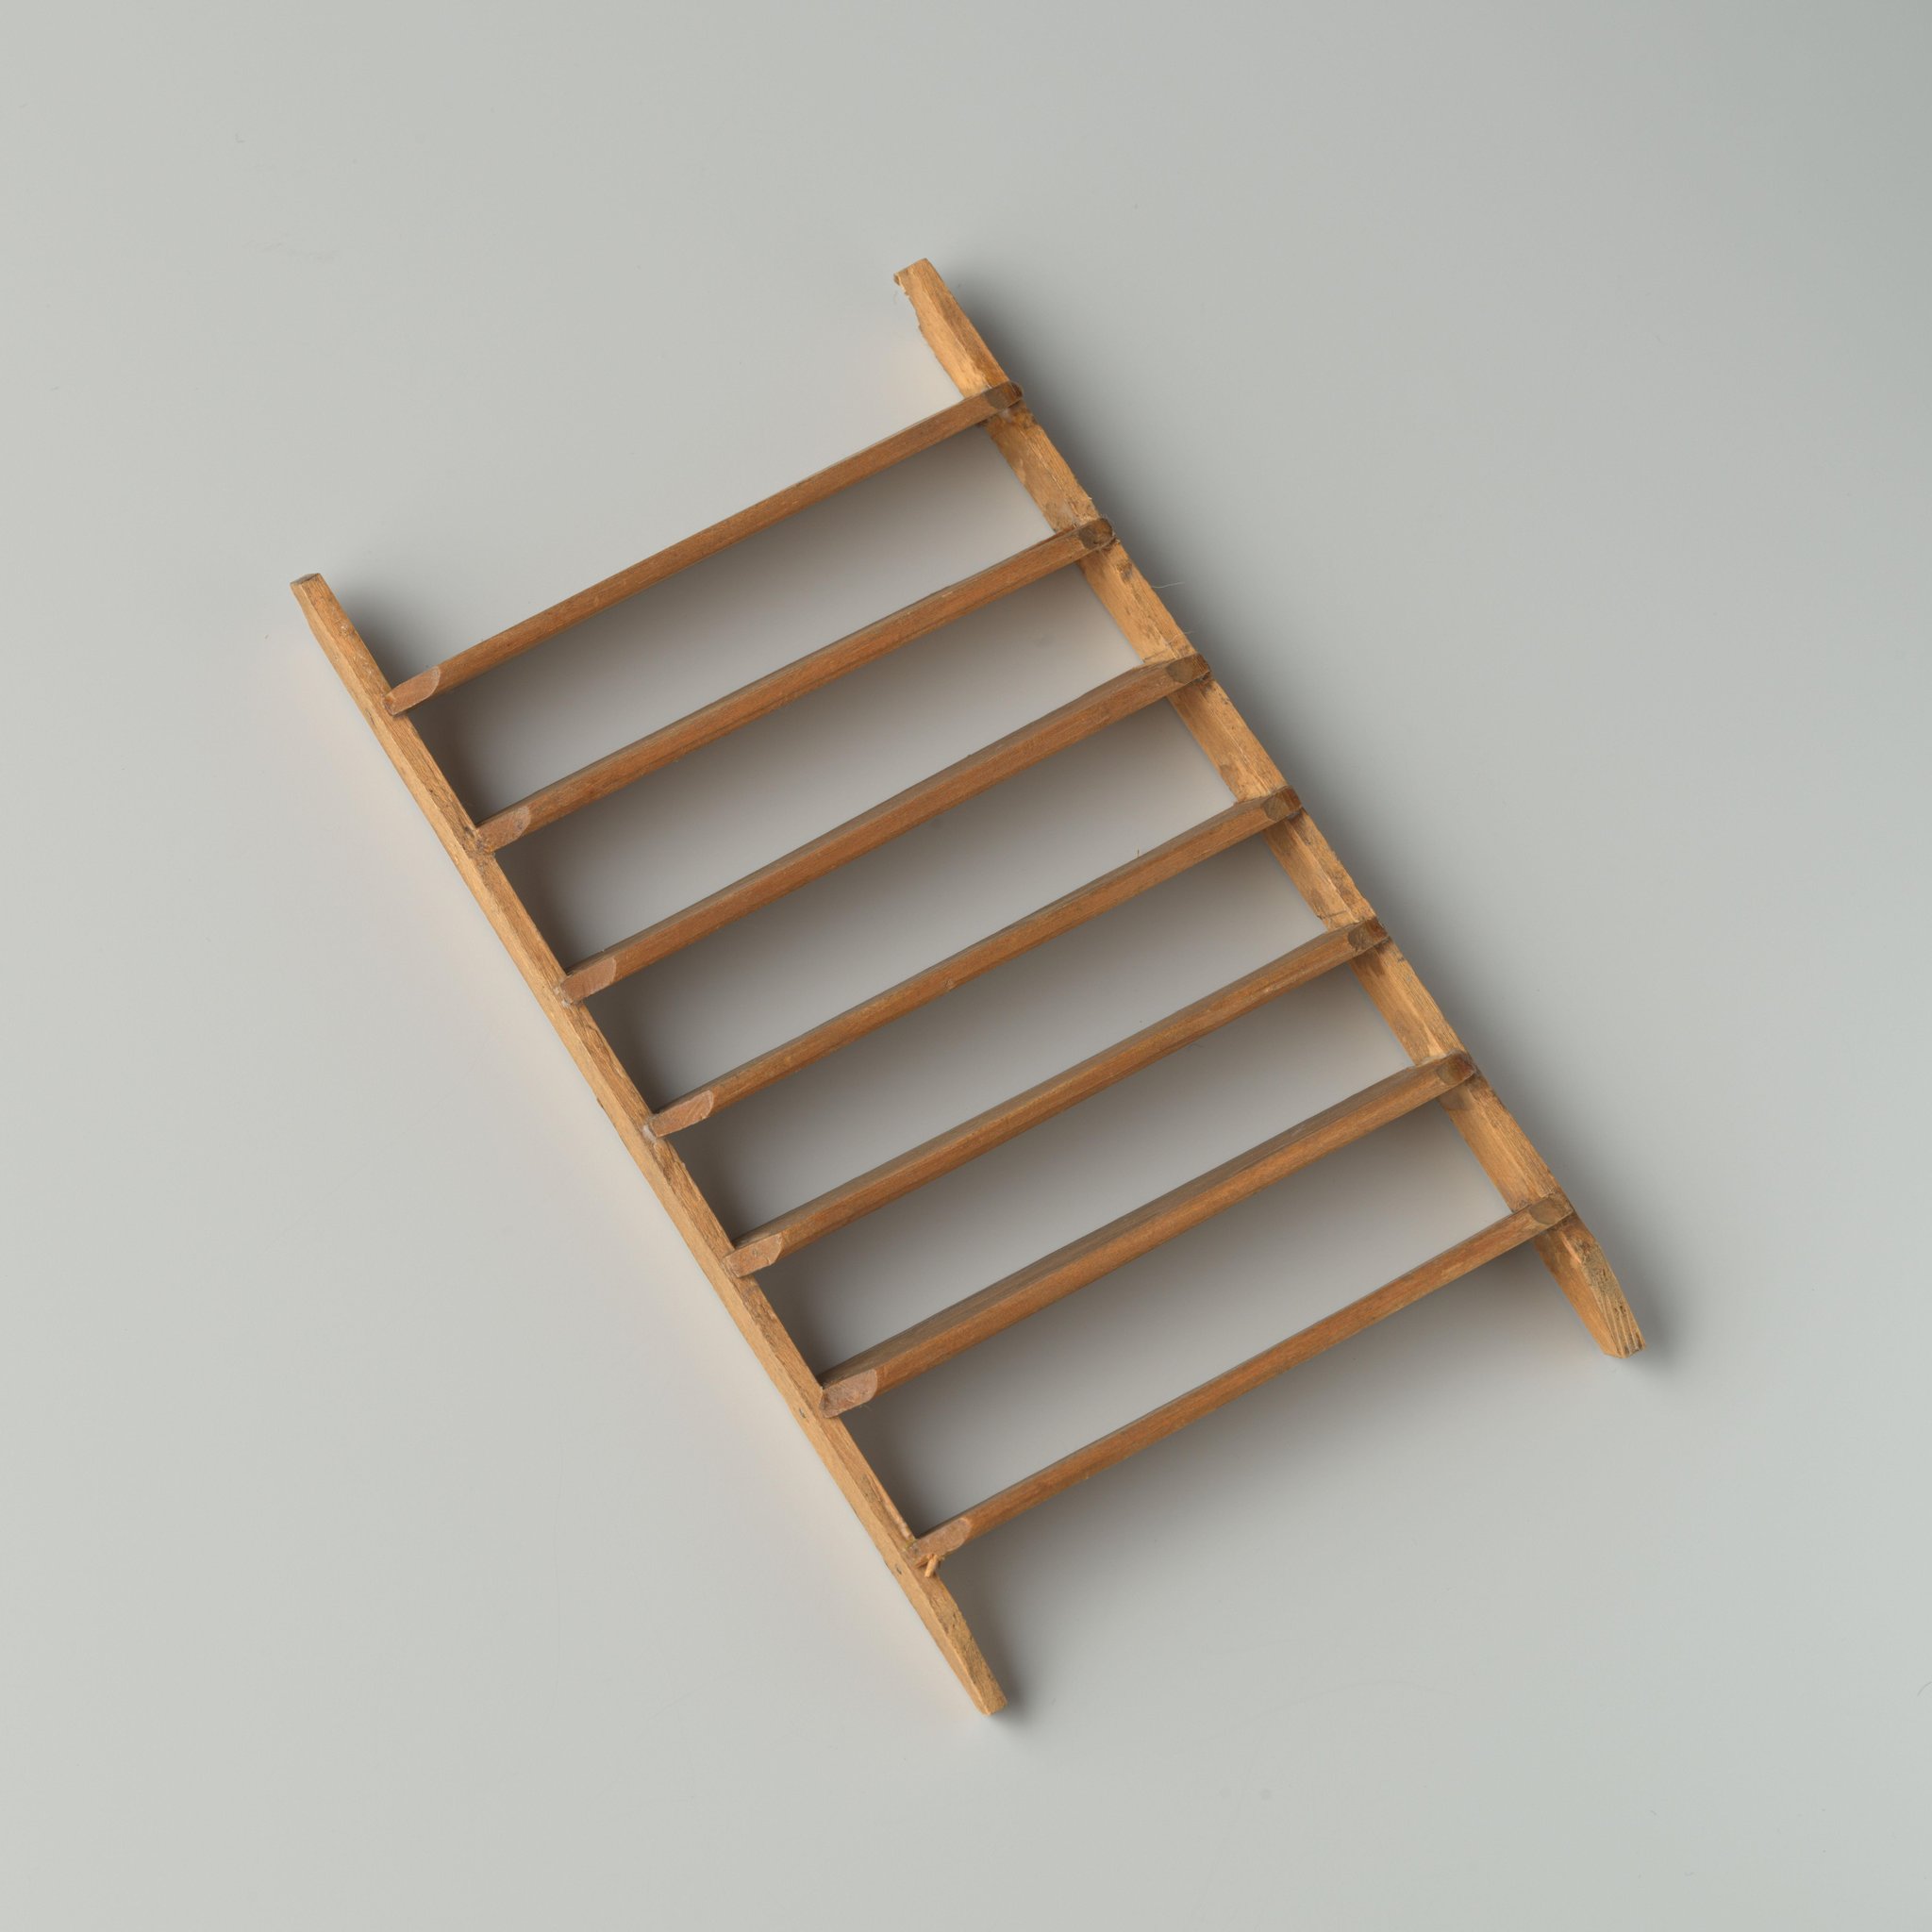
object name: stair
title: Trap van without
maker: Anonymous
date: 1676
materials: without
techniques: without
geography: amsterdam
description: Trap vervaardigd van without, met twee zijschotten en zeven traptreden, die aan de voorzijde iets uitsteken en aan de zijkanten uitgehold zijn.